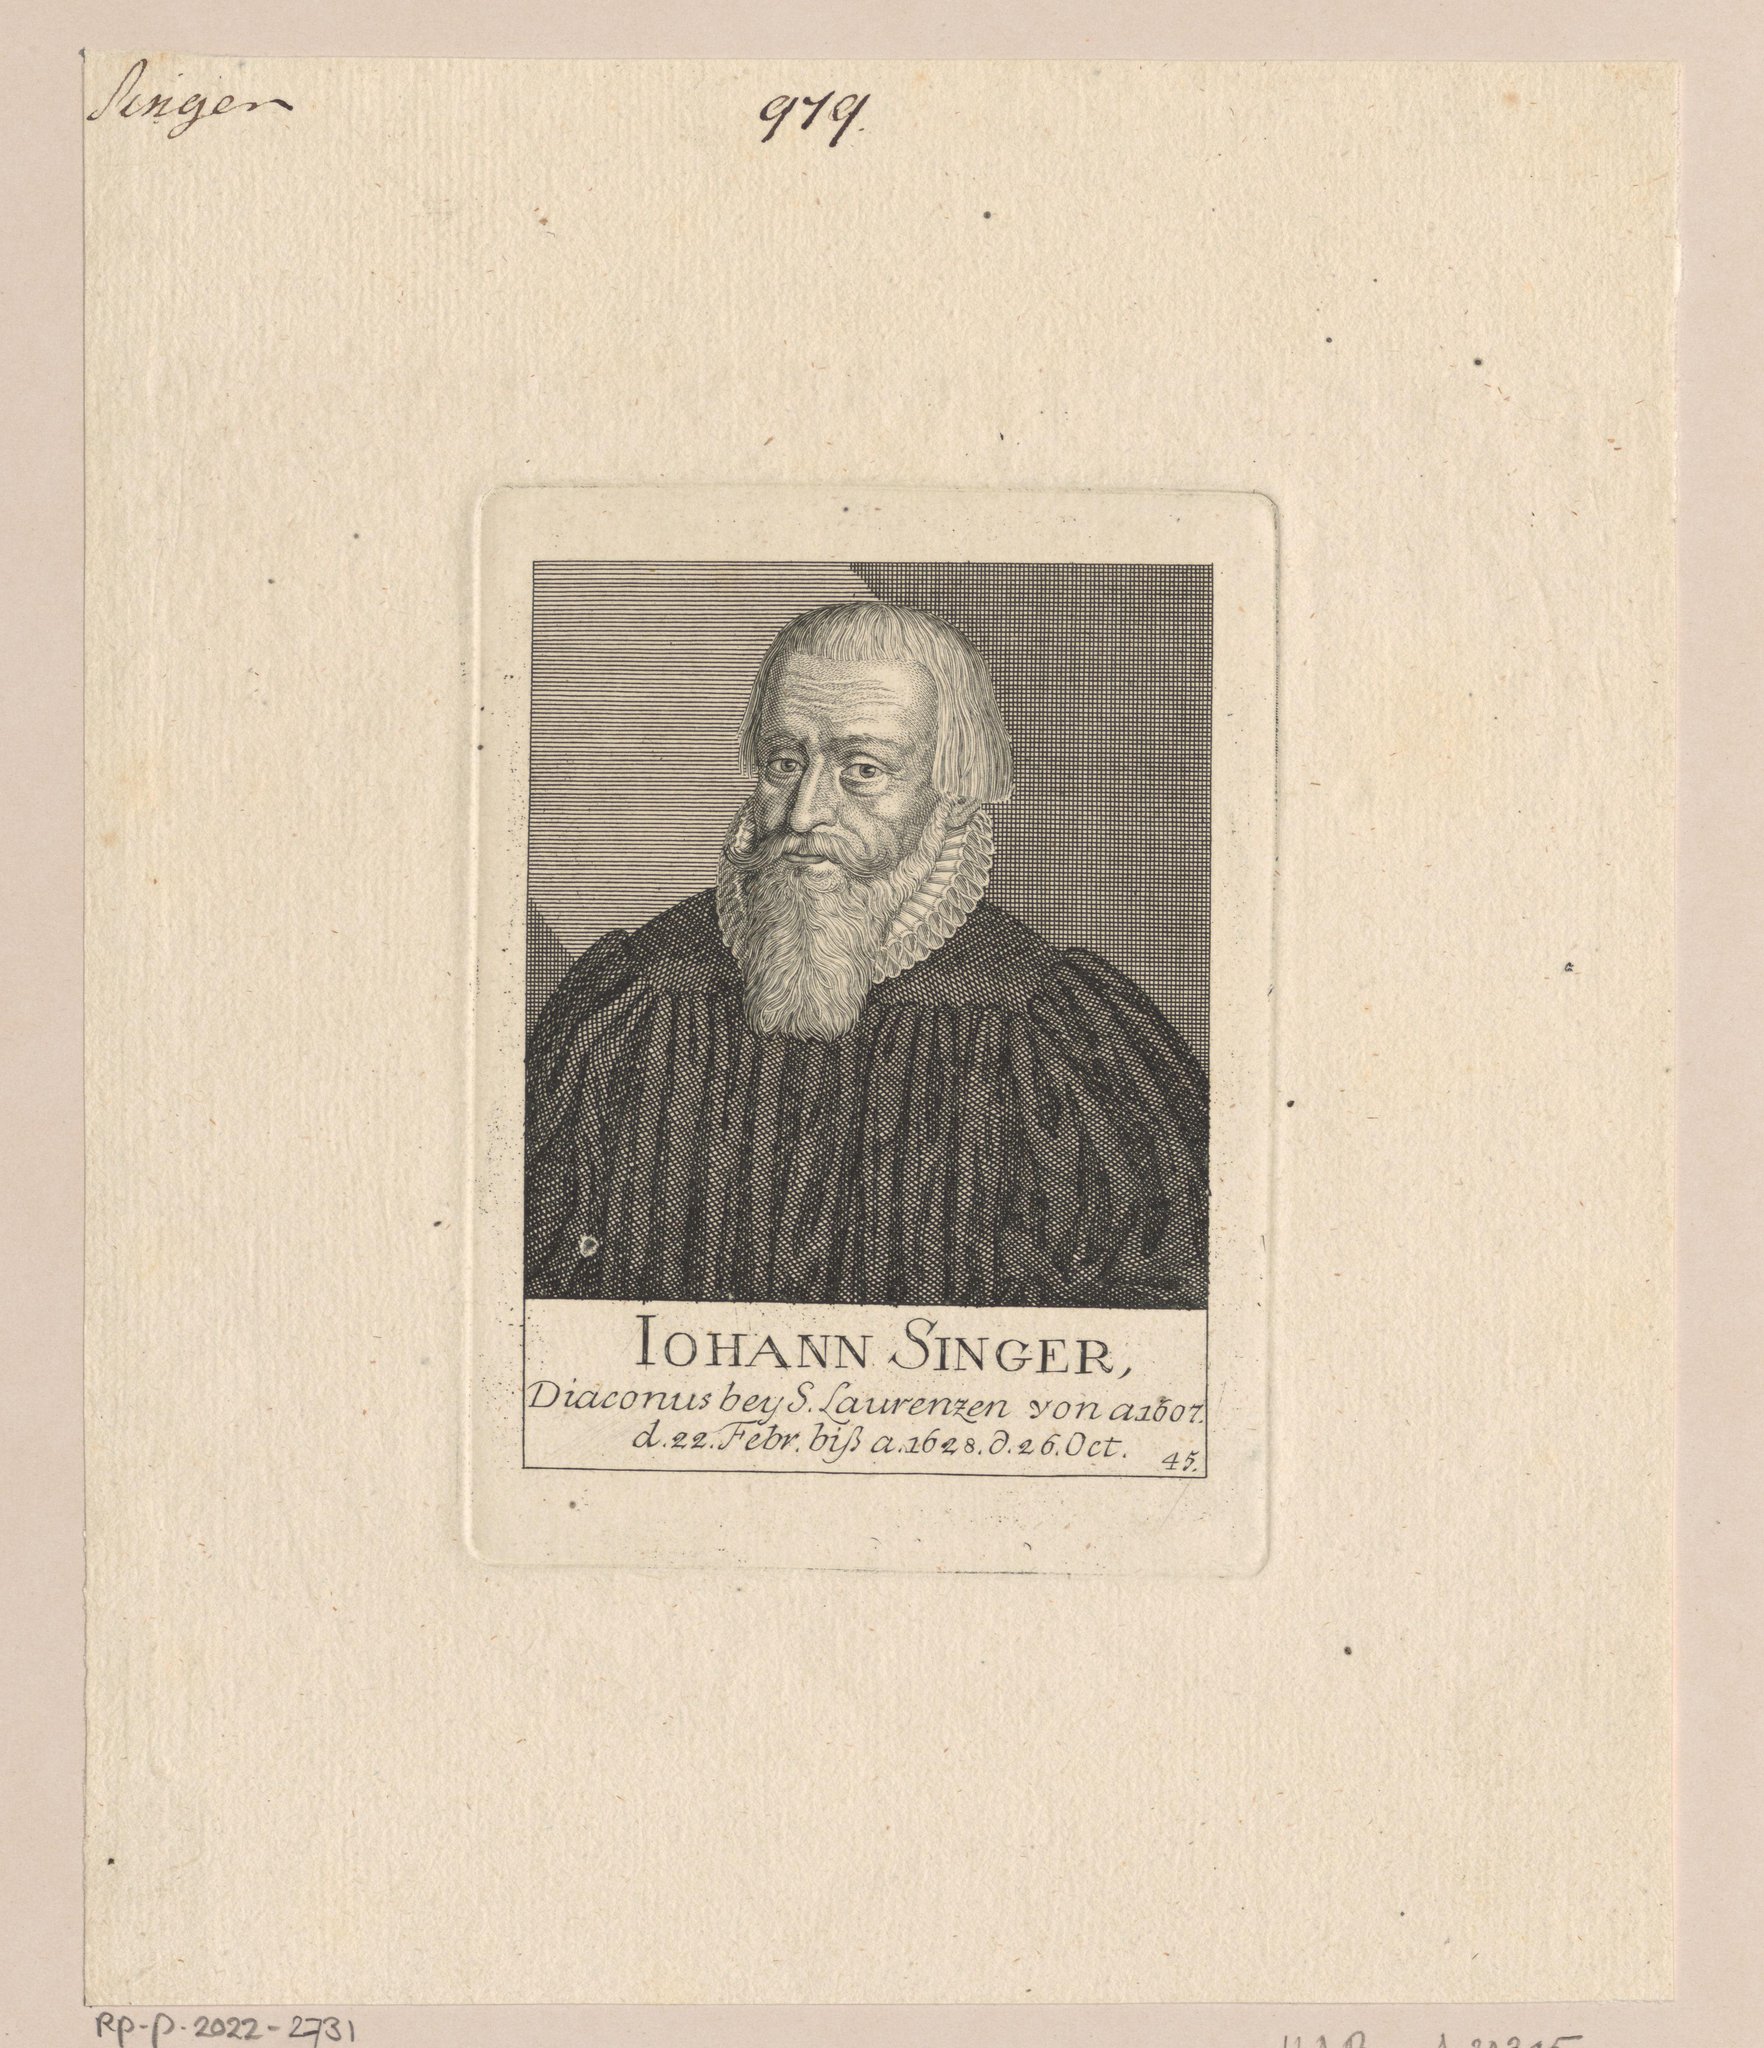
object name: print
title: Portret van Johann Singer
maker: christoph melchior roth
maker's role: print maker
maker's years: 1720-1798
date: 1756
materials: paper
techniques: engraving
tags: theologian, historical persons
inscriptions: number: ‘979’, name: ‘Singer’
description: Prent uit: Würfel, Andreas. Diptycha ecclesiae Laurentianae (...). Neurenberg: Christoph Melchior Roth, 1756.